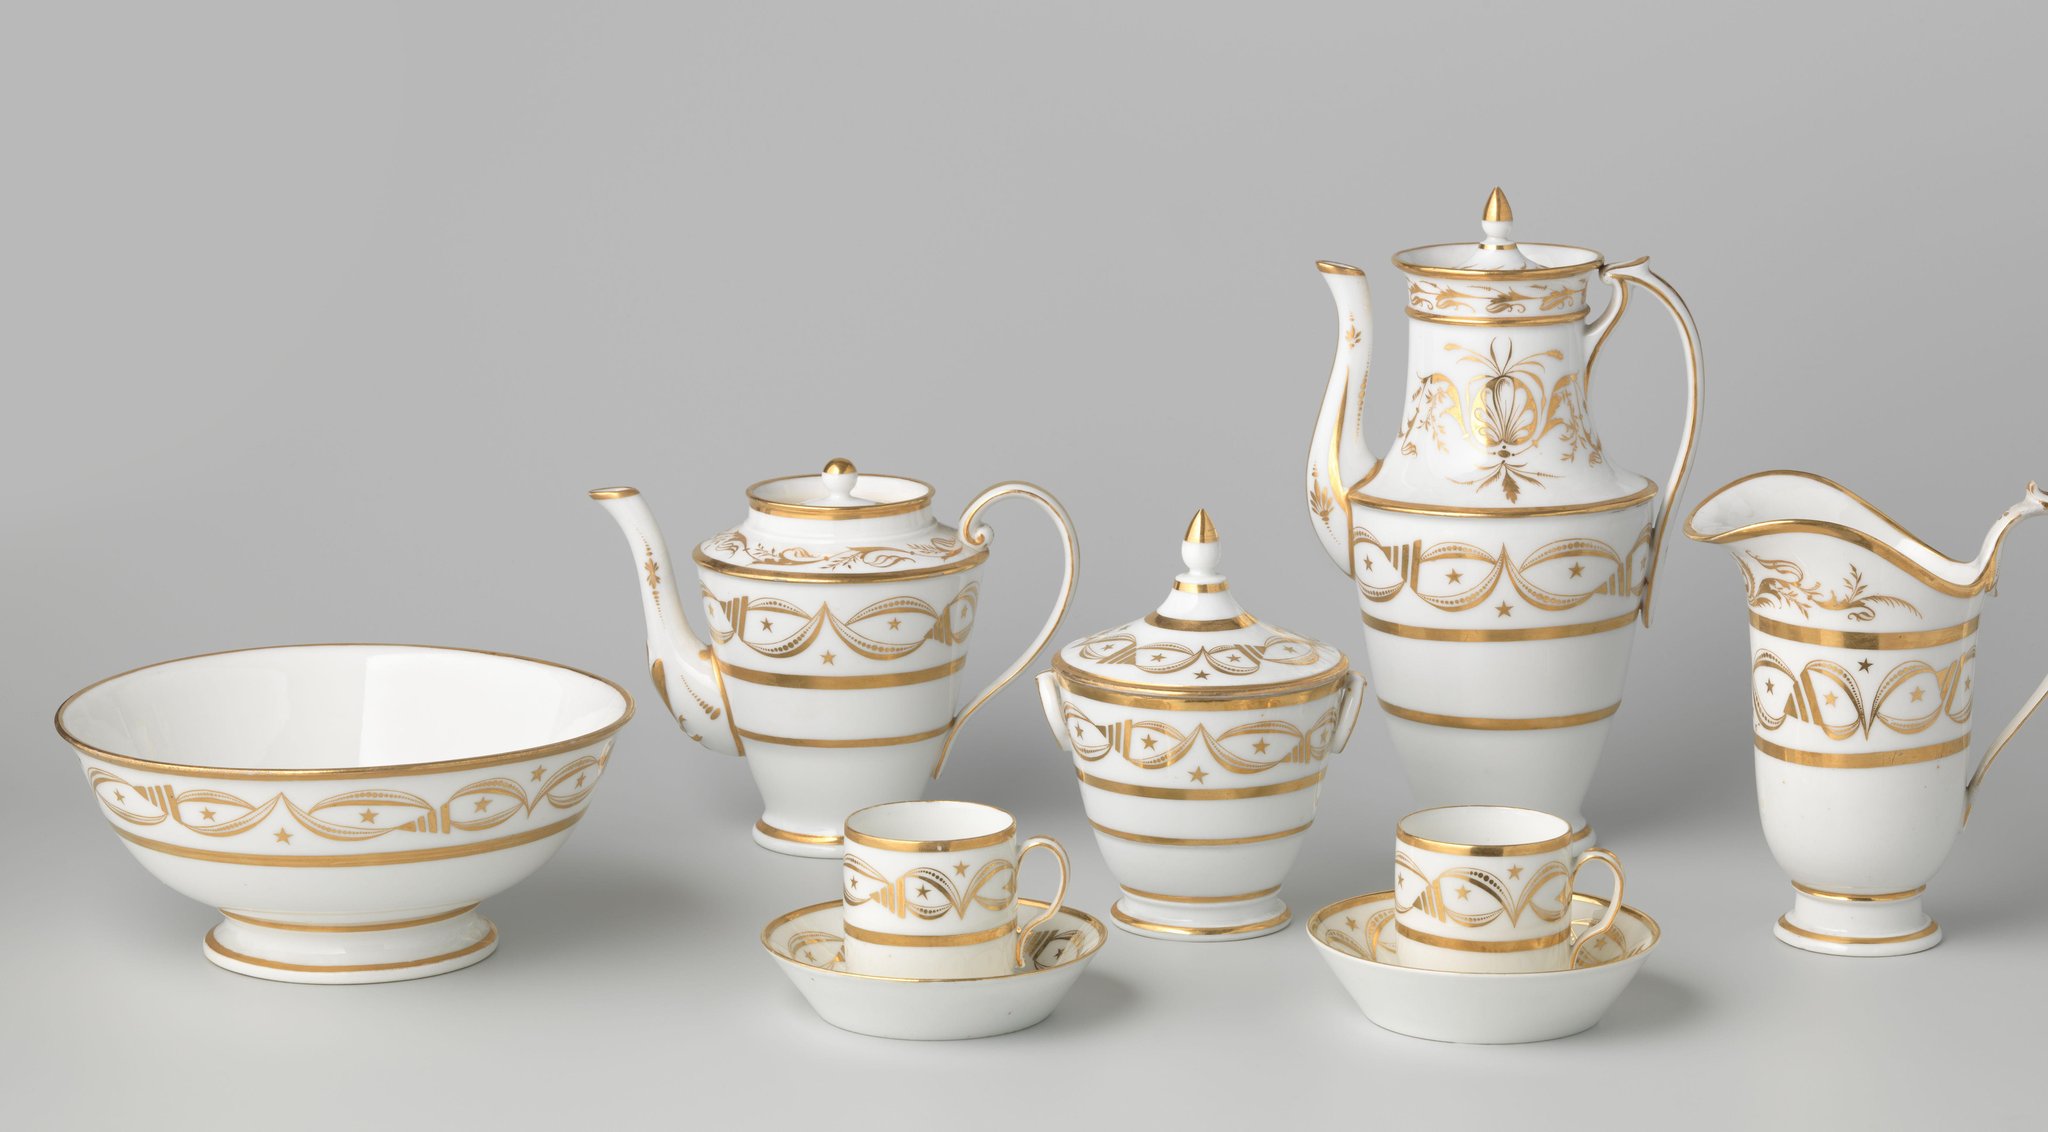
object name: service set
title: Service with stylized flower sprays and ornamental borders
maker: Anonymous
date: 1800-1824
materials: glaze, gold, paint, porcelain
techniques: firing, forming, gilding, turning, vitrification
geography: france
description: Servies van porselein, beschilderd op het glazuur in goud. Het servies bestaat uit een koffiepot, theepot, melkkan, suikerpot, kom en twaalf koppen met schotels. Versierd met gestileerde bloemtakken en decoratieve banden. Empire.